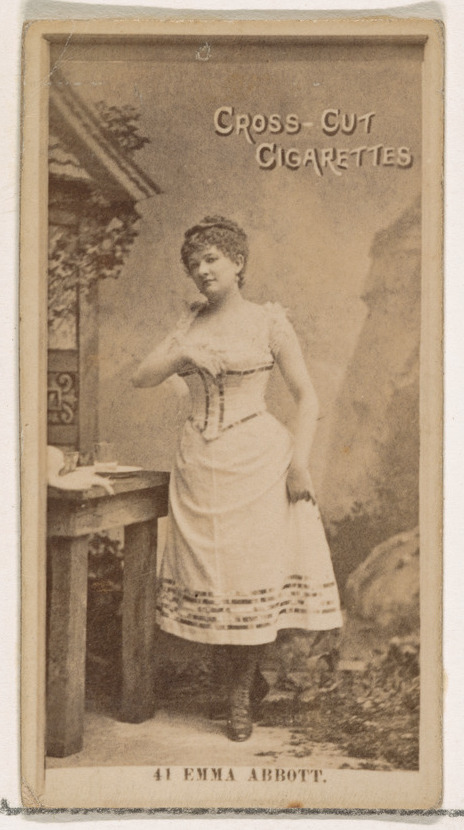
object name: print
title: Card Number 41, Emma Abbott, from the Actors and Actresses series (N145-2) issued by Duke Sons & Co. to promote Cross Cut Cigarettes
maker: w. duke, sons & co.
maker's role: publisher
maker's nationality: american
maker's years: 1870-1920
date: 1880-1889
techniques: albumen silver print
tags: portraits,women,actresses